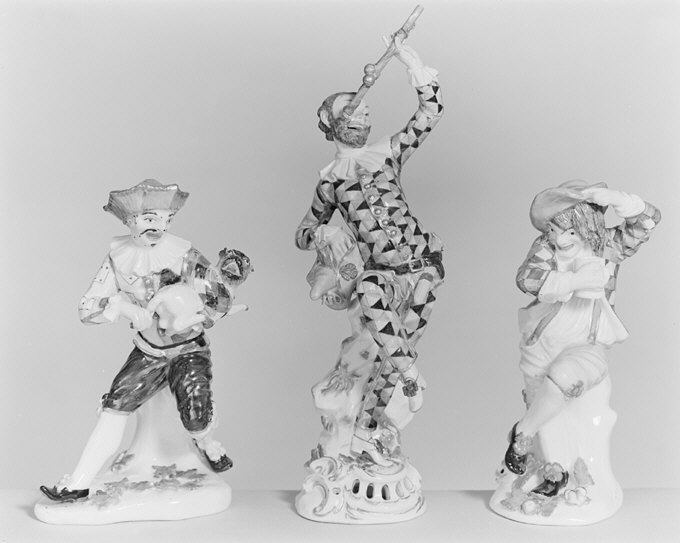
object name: figure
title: Peasant drinking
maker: meissen manufactory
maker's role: manufactory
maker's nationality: german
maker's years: 1710-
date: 1740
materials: hard paste porcelain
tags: men